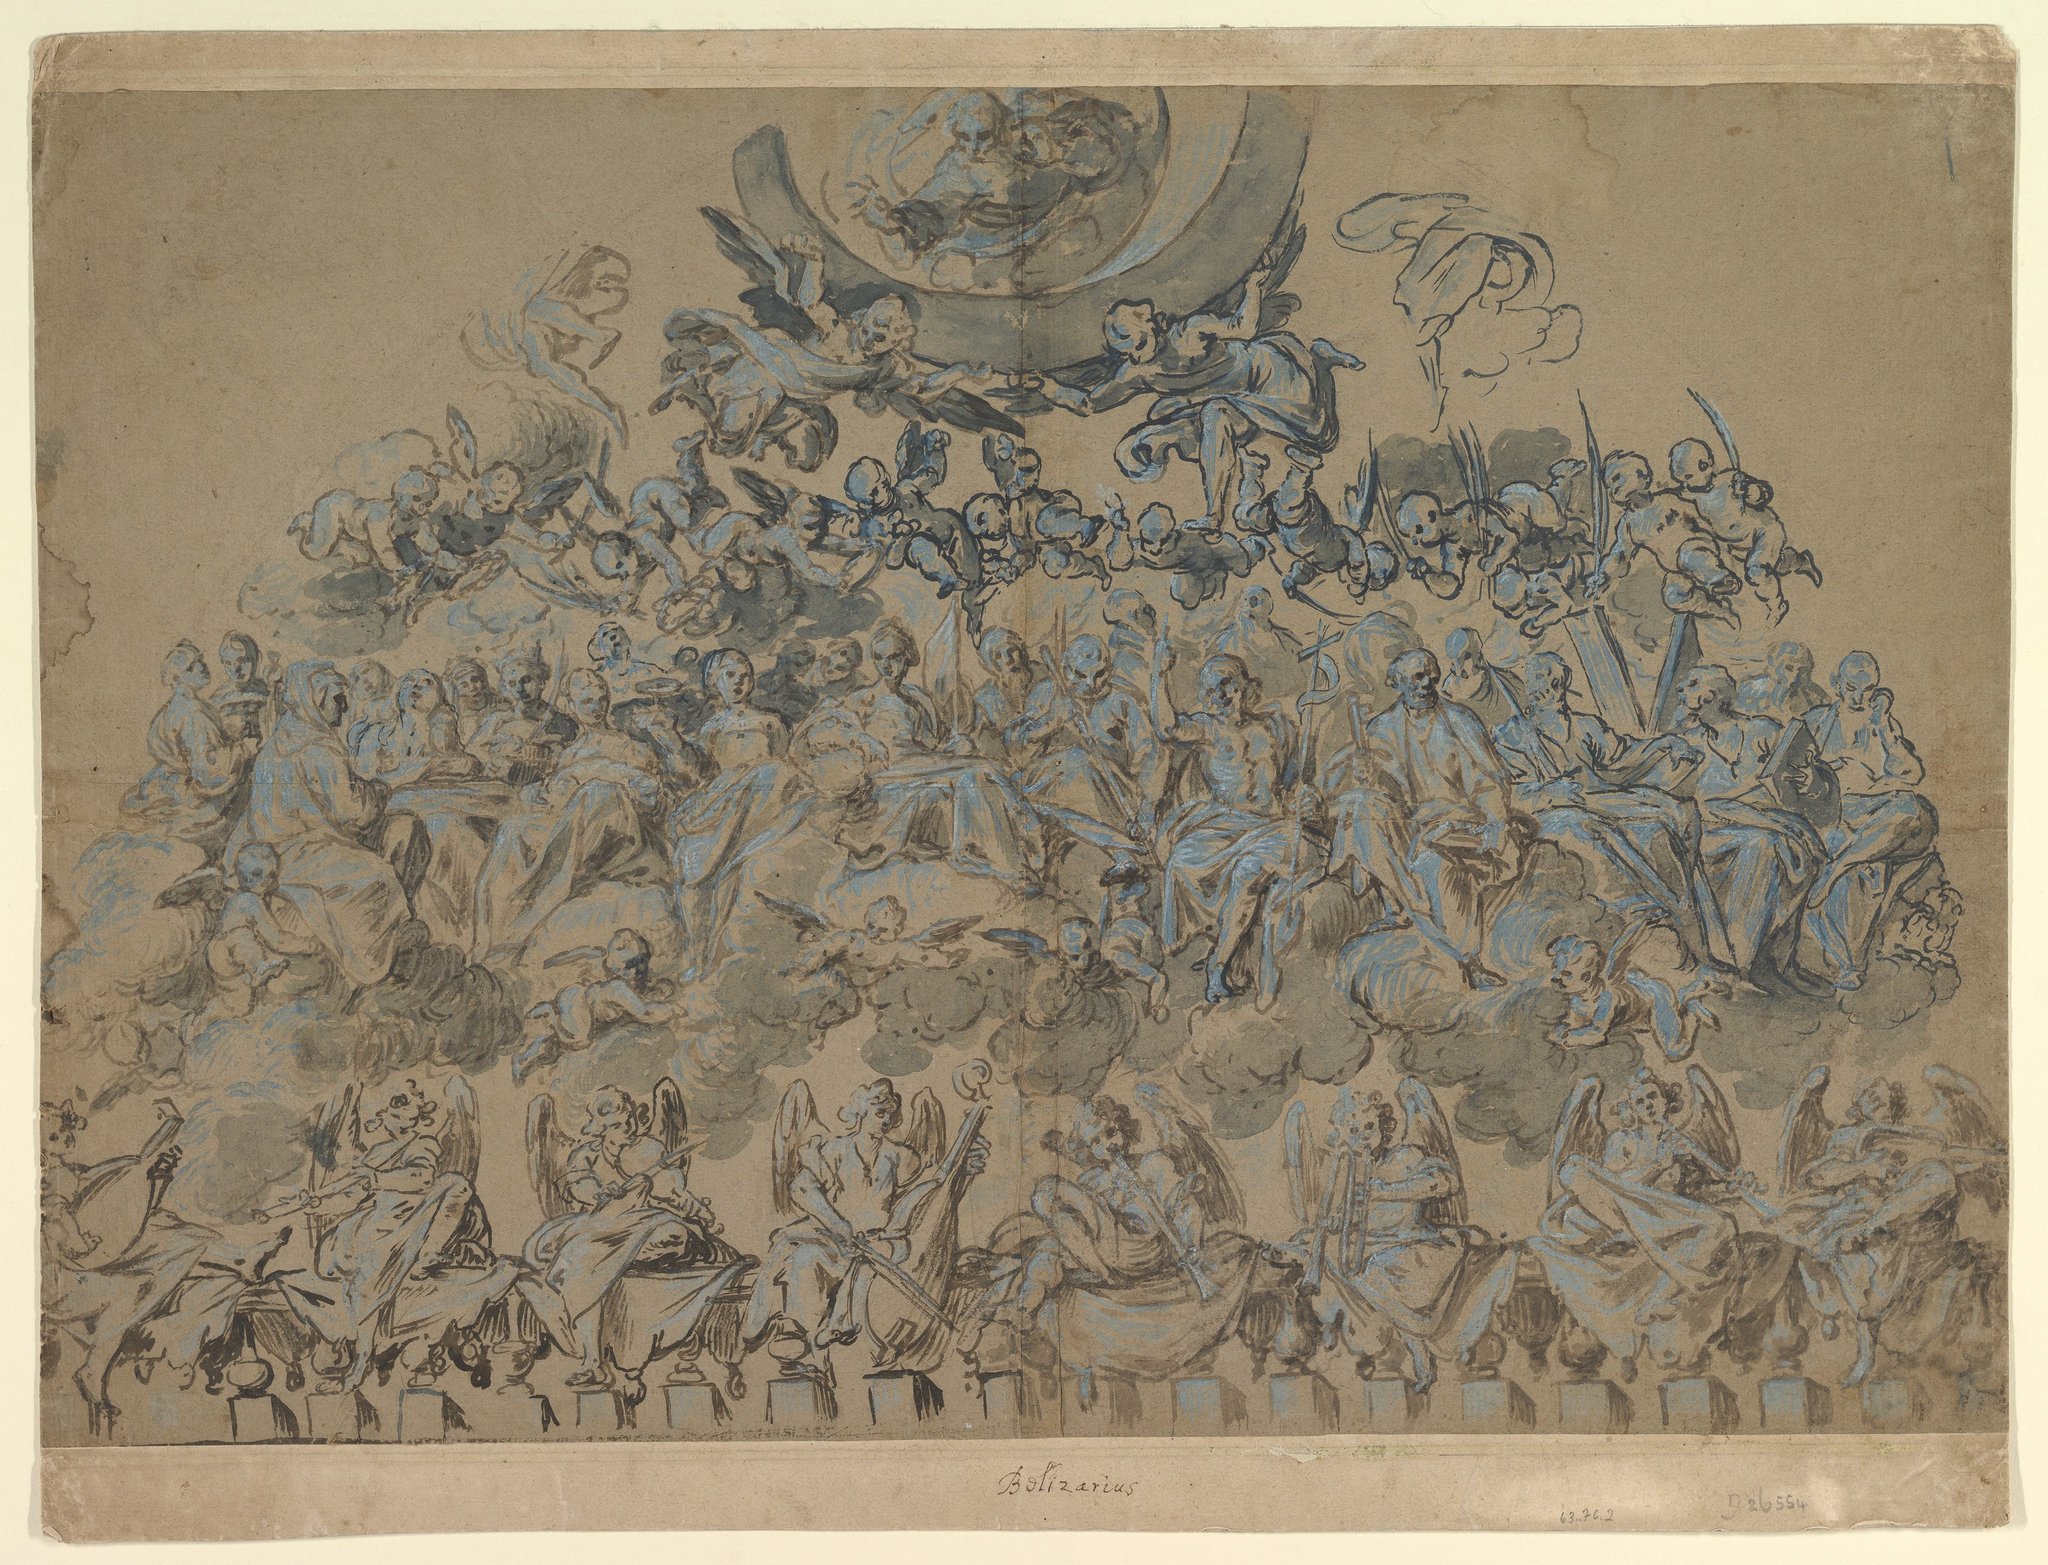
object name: drawing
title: Study for the Decoration of an Apse: Saints and Angels in Glory with God the Father Above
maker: belisario corenzio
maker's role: artist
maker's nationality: italian, born greece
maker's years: 1558-1646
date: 1590-1646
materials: chalk, paper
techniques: brush, highlighting, wash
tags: musical instruments,angels,saints